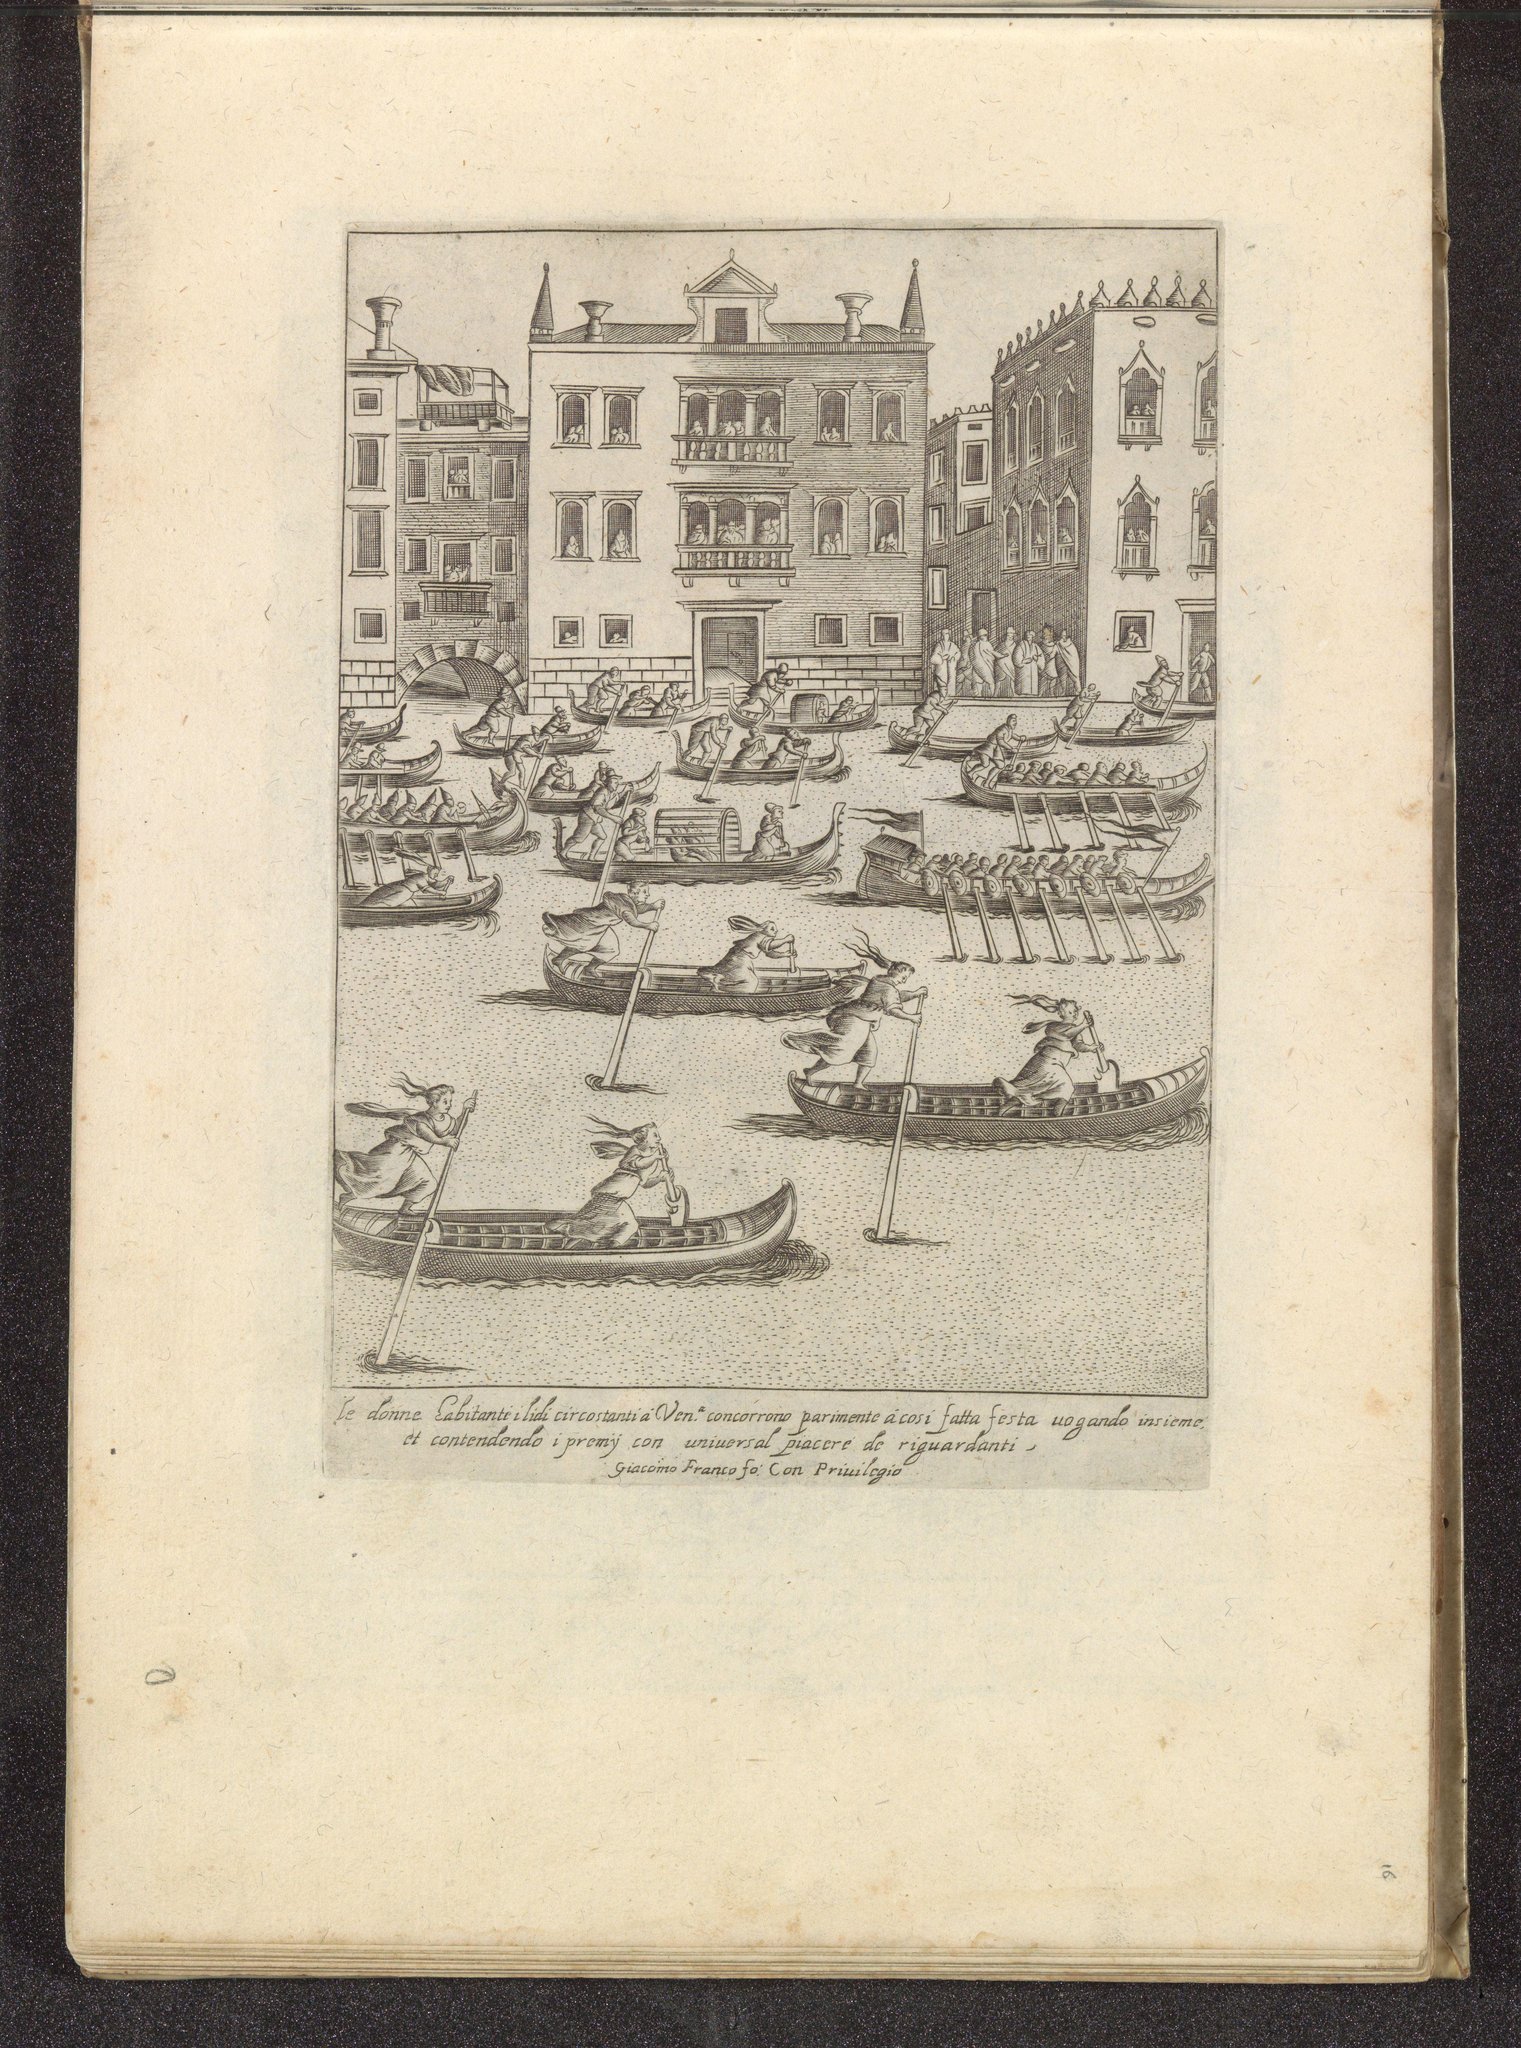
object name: print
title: Habiti d'Huomeni e Donne Venetiane Con la Processione della Ser.ma Signoria Et altri particolari cioè Trionfi feste et cerimonie publiche della nobilissima città di Venetia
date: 1610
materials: paper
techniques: engraving, intaglio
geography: venice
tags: rowing-boat, canoe, etc., gondola, venice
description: Op de voorgrond een wedstrijd van gondels en roeiboten. De gondels worden bestuurd door vrouwen. Vanuit de aan het water gelegen palazzi wordt toegekeken. Tweeregelige Italiaanse tekst in ondermarge. De prent maakt deel uit van een album.